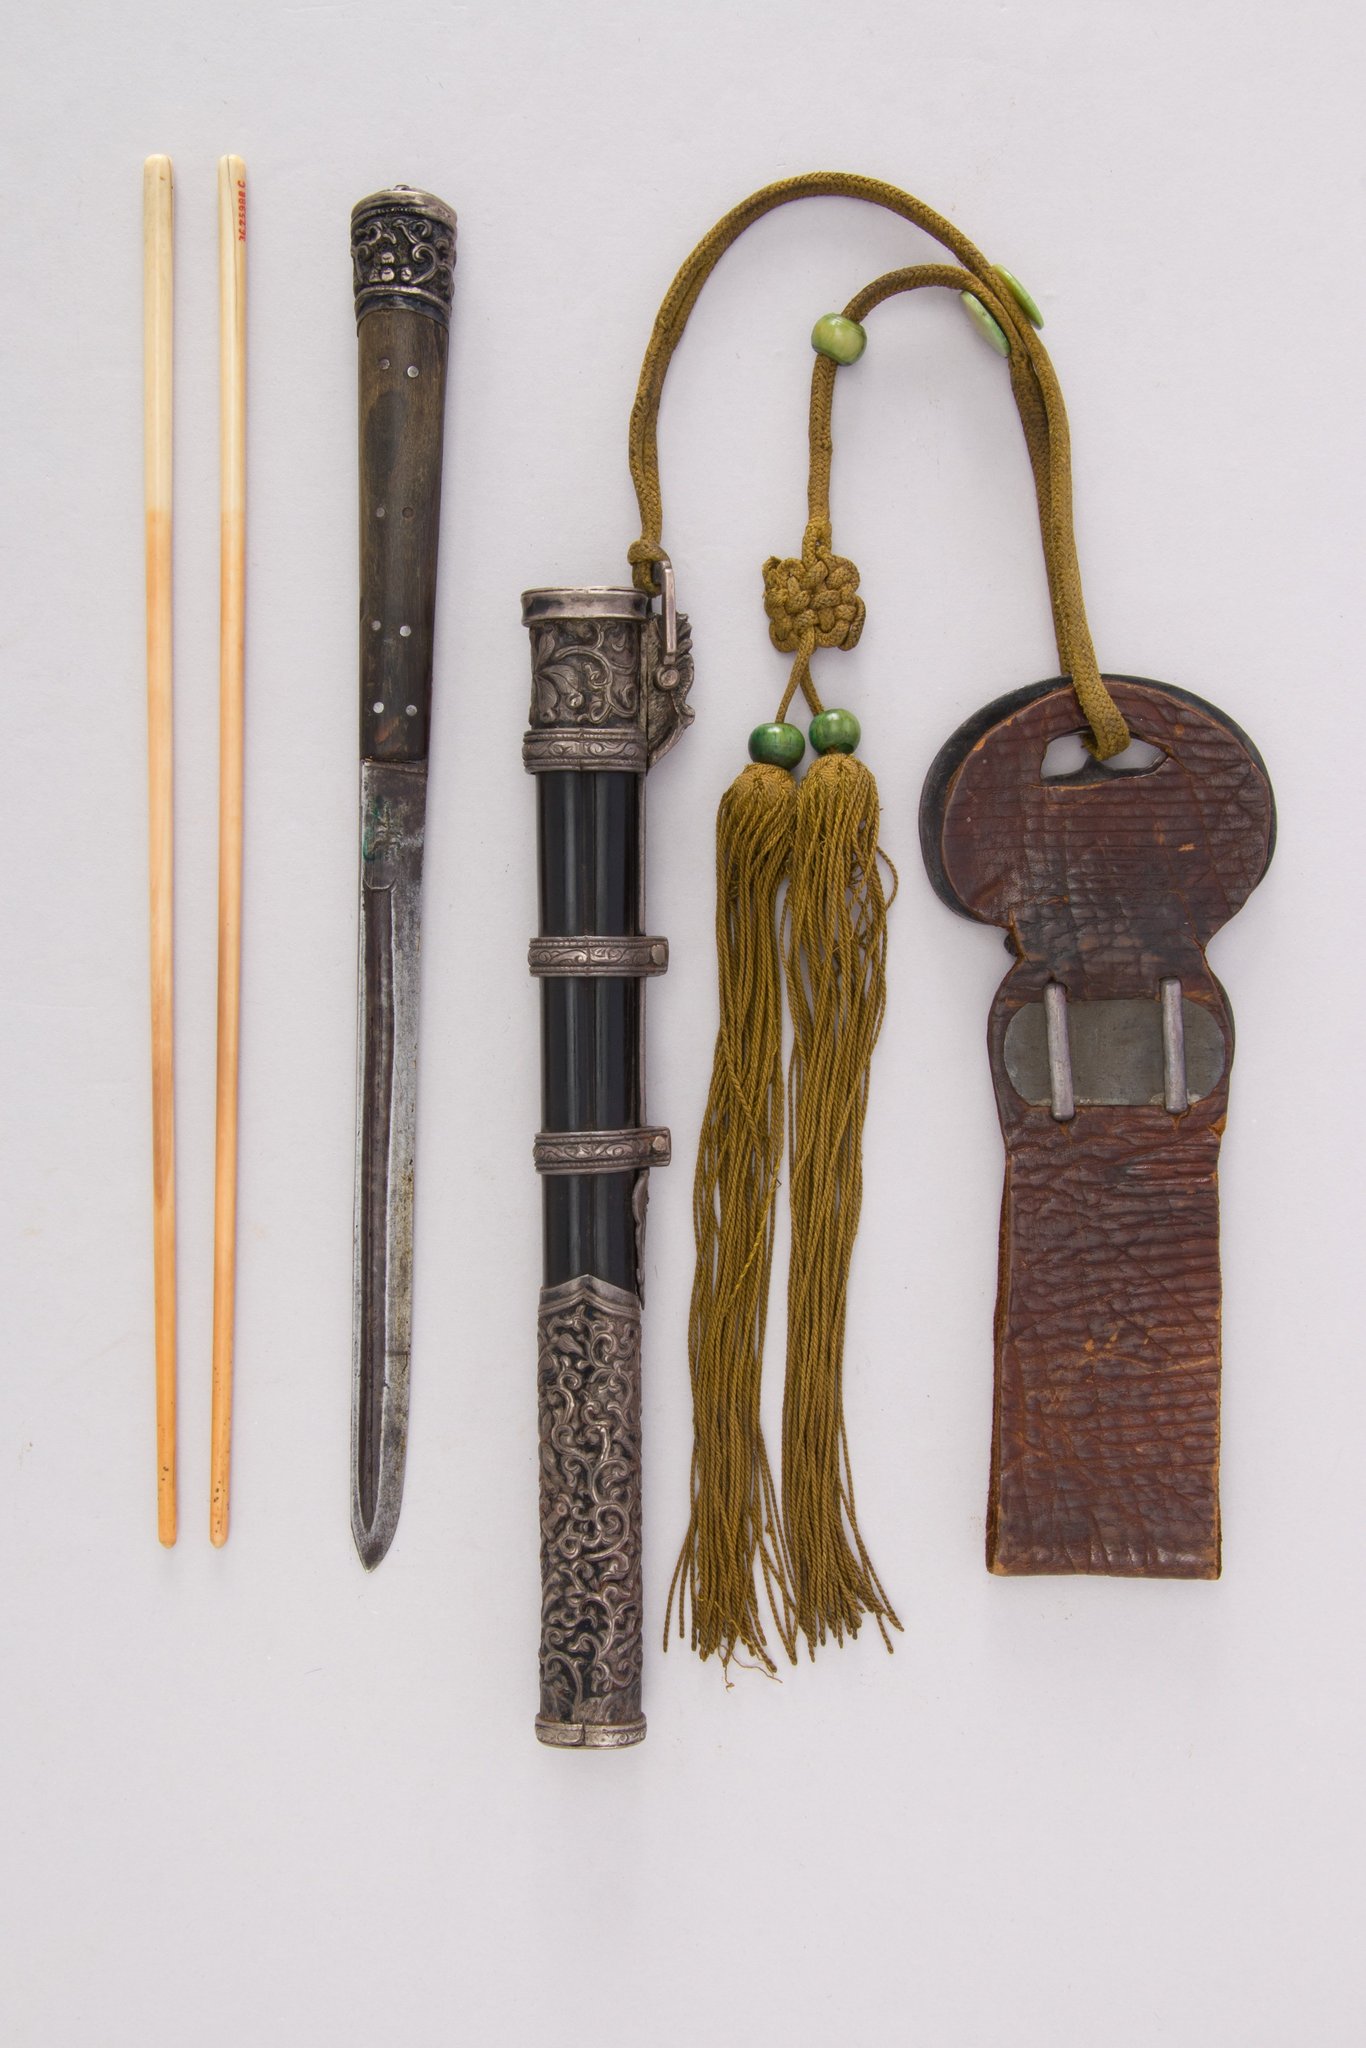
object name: knife with sheath, belt, and chopstick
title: Knife with Sheath, Chopsticks and Belt Loop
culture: chinese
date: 1750-1900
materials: brass, coral, wood, ivory, leather, silver, steel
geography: china